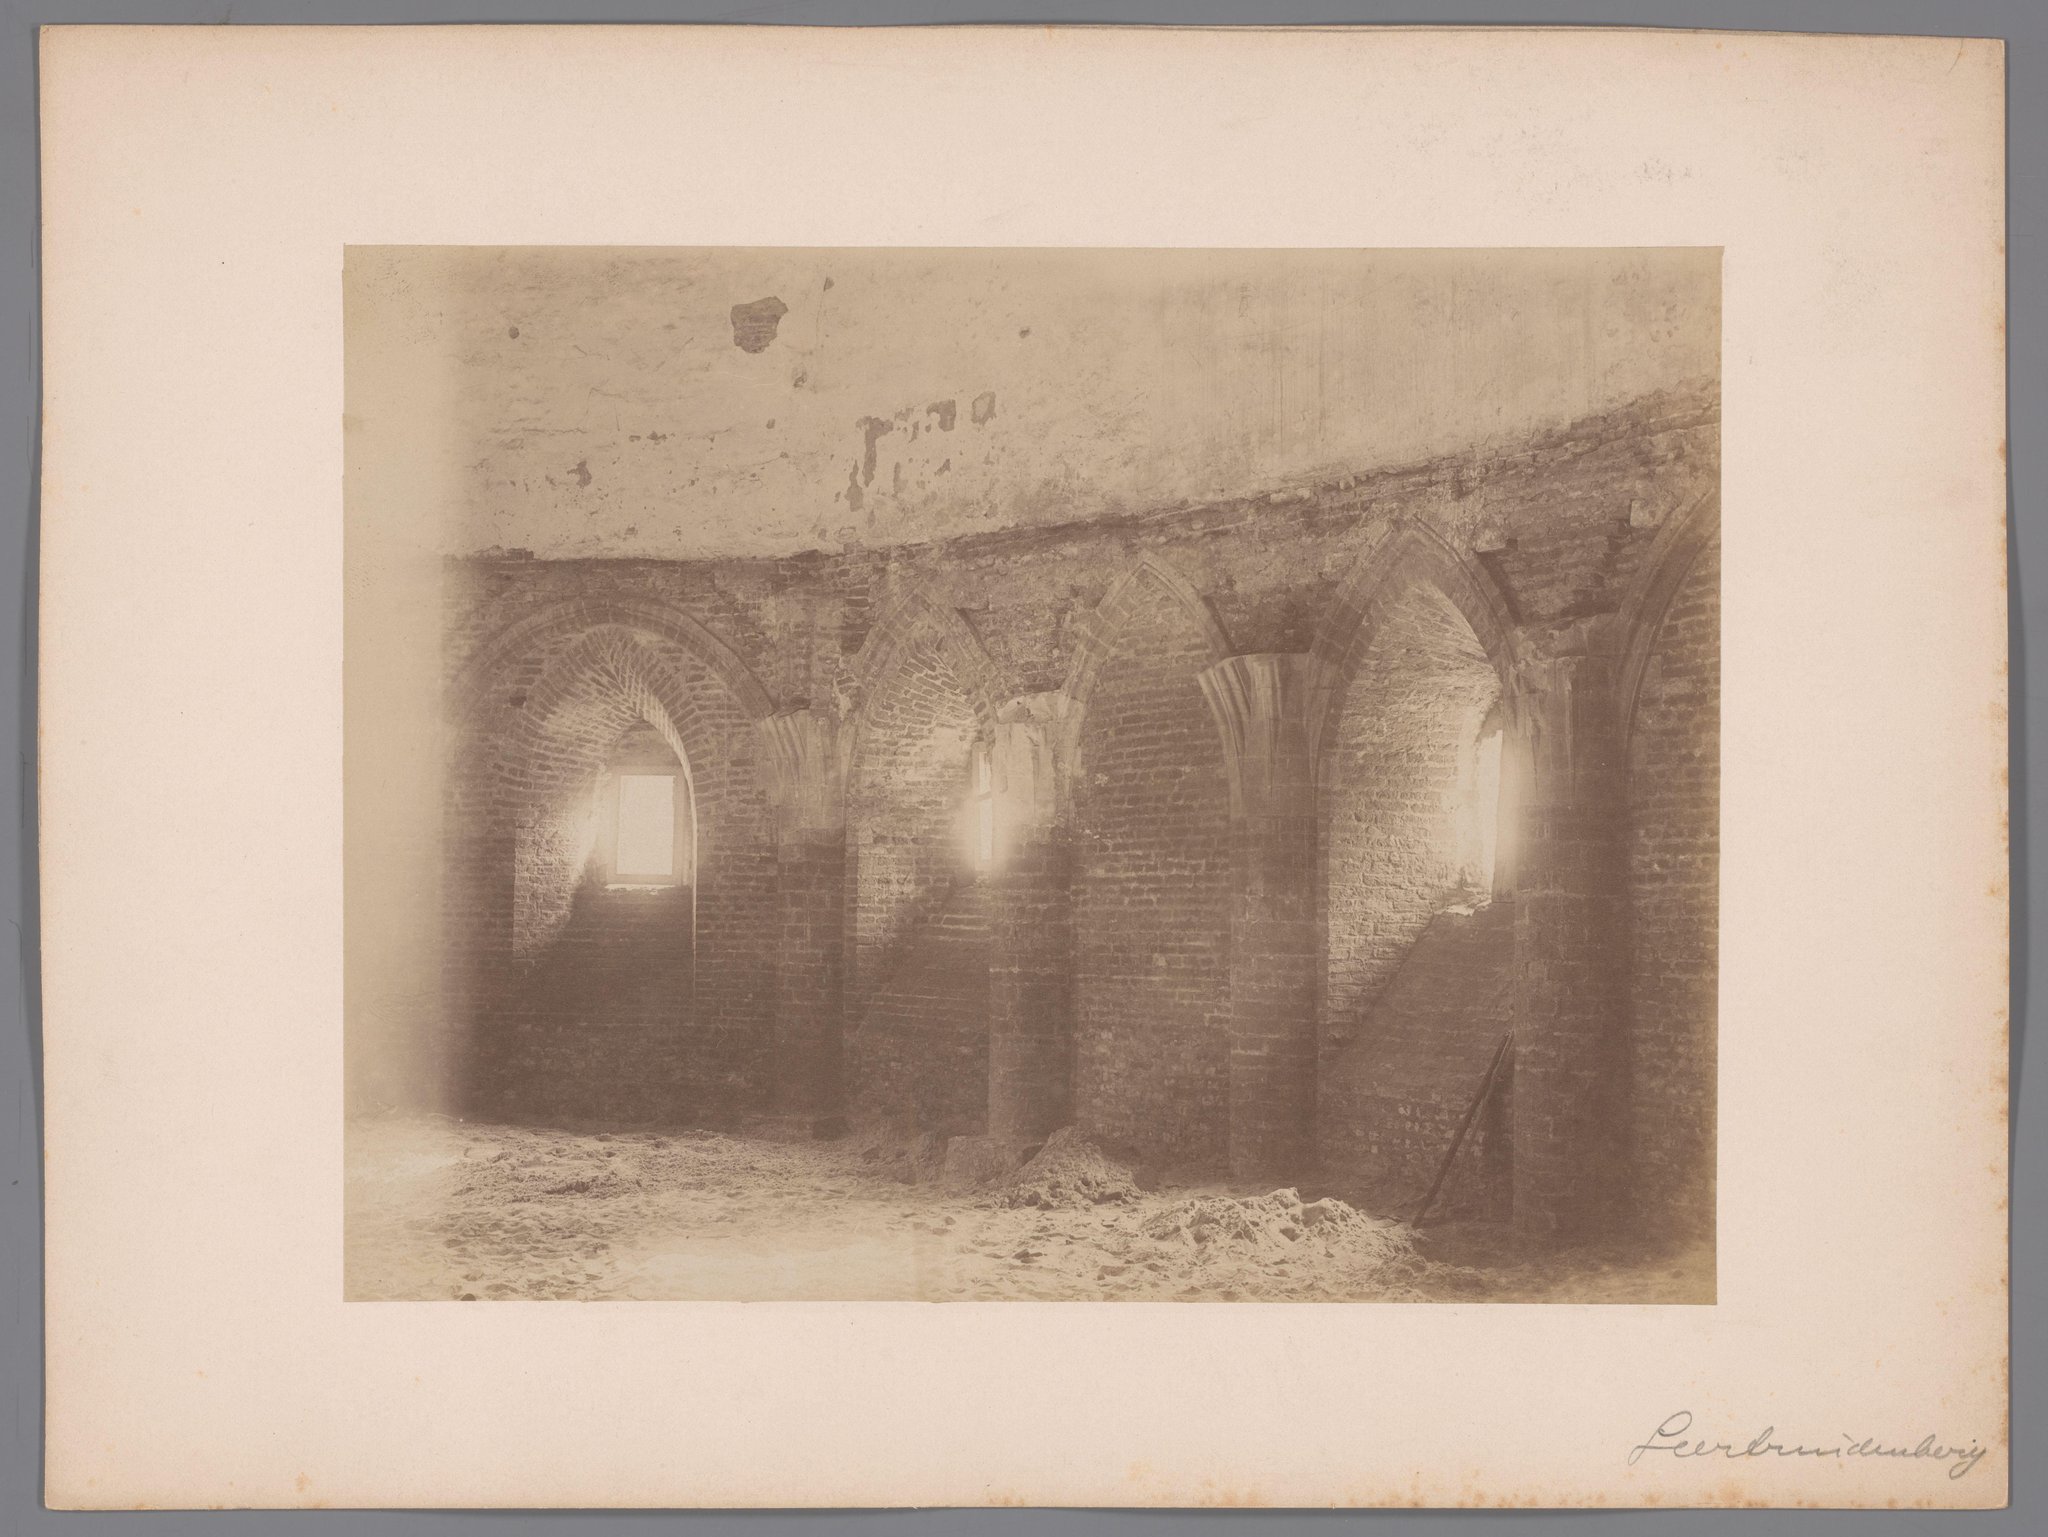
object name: photograph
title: Interieur van een ontgraven crypte in de Geertruidskerk te Geertruidenberg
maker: anoniem (monumentenzorg)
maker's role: fotograaf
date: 1895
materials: cardboard, photographic support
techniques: albumen print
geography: geertruidenberg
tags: parts of church interior (crypt), geertruidenberg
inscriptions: annotation: ‘Geertruidenberg’, annotation: ‘Zuidoost hoek v/d ontgraven krocht in de N.H. Kerk te Geertruidenberg (N.B.)/ oct 1895’